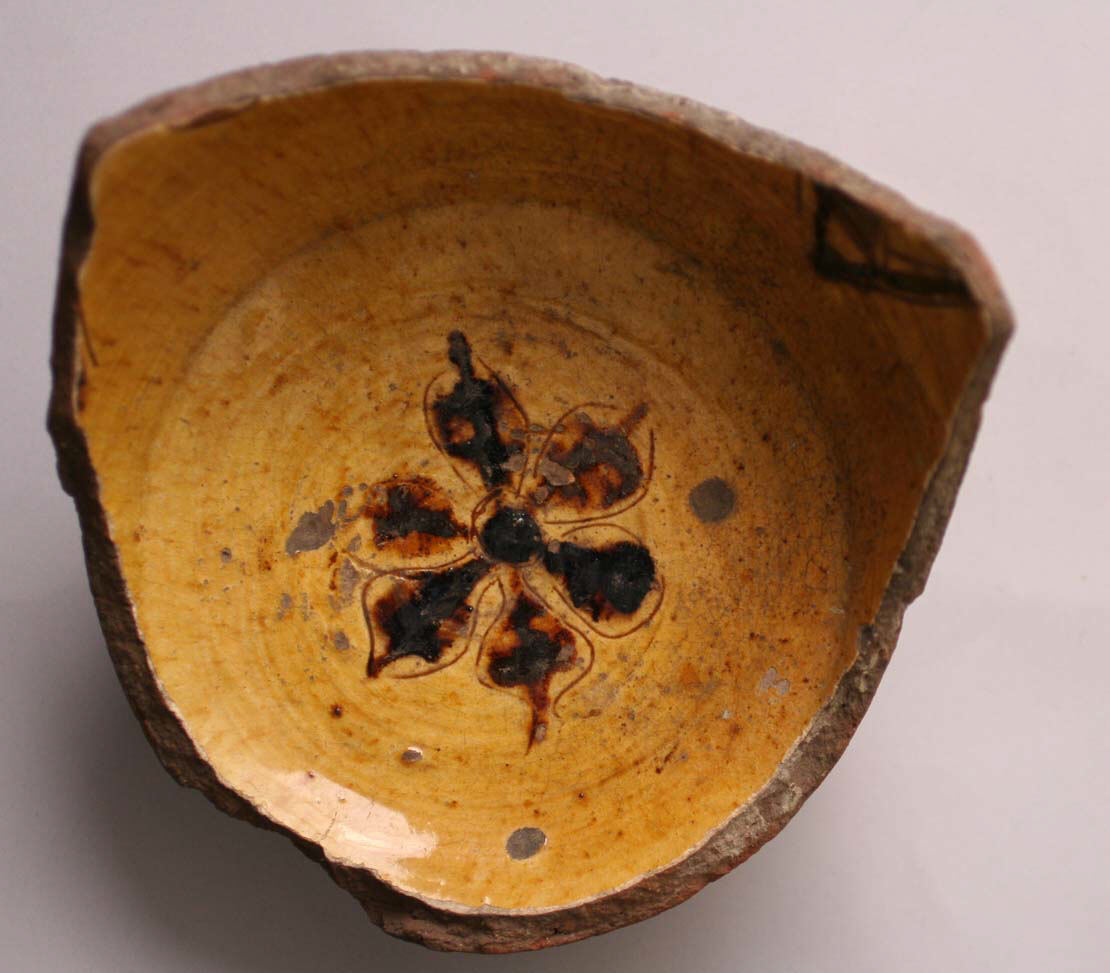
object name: fragment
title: Fragment of a Bowl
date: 1301-1500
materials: earthenware, glaze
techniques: coloring, incising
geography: egypt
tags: flowers